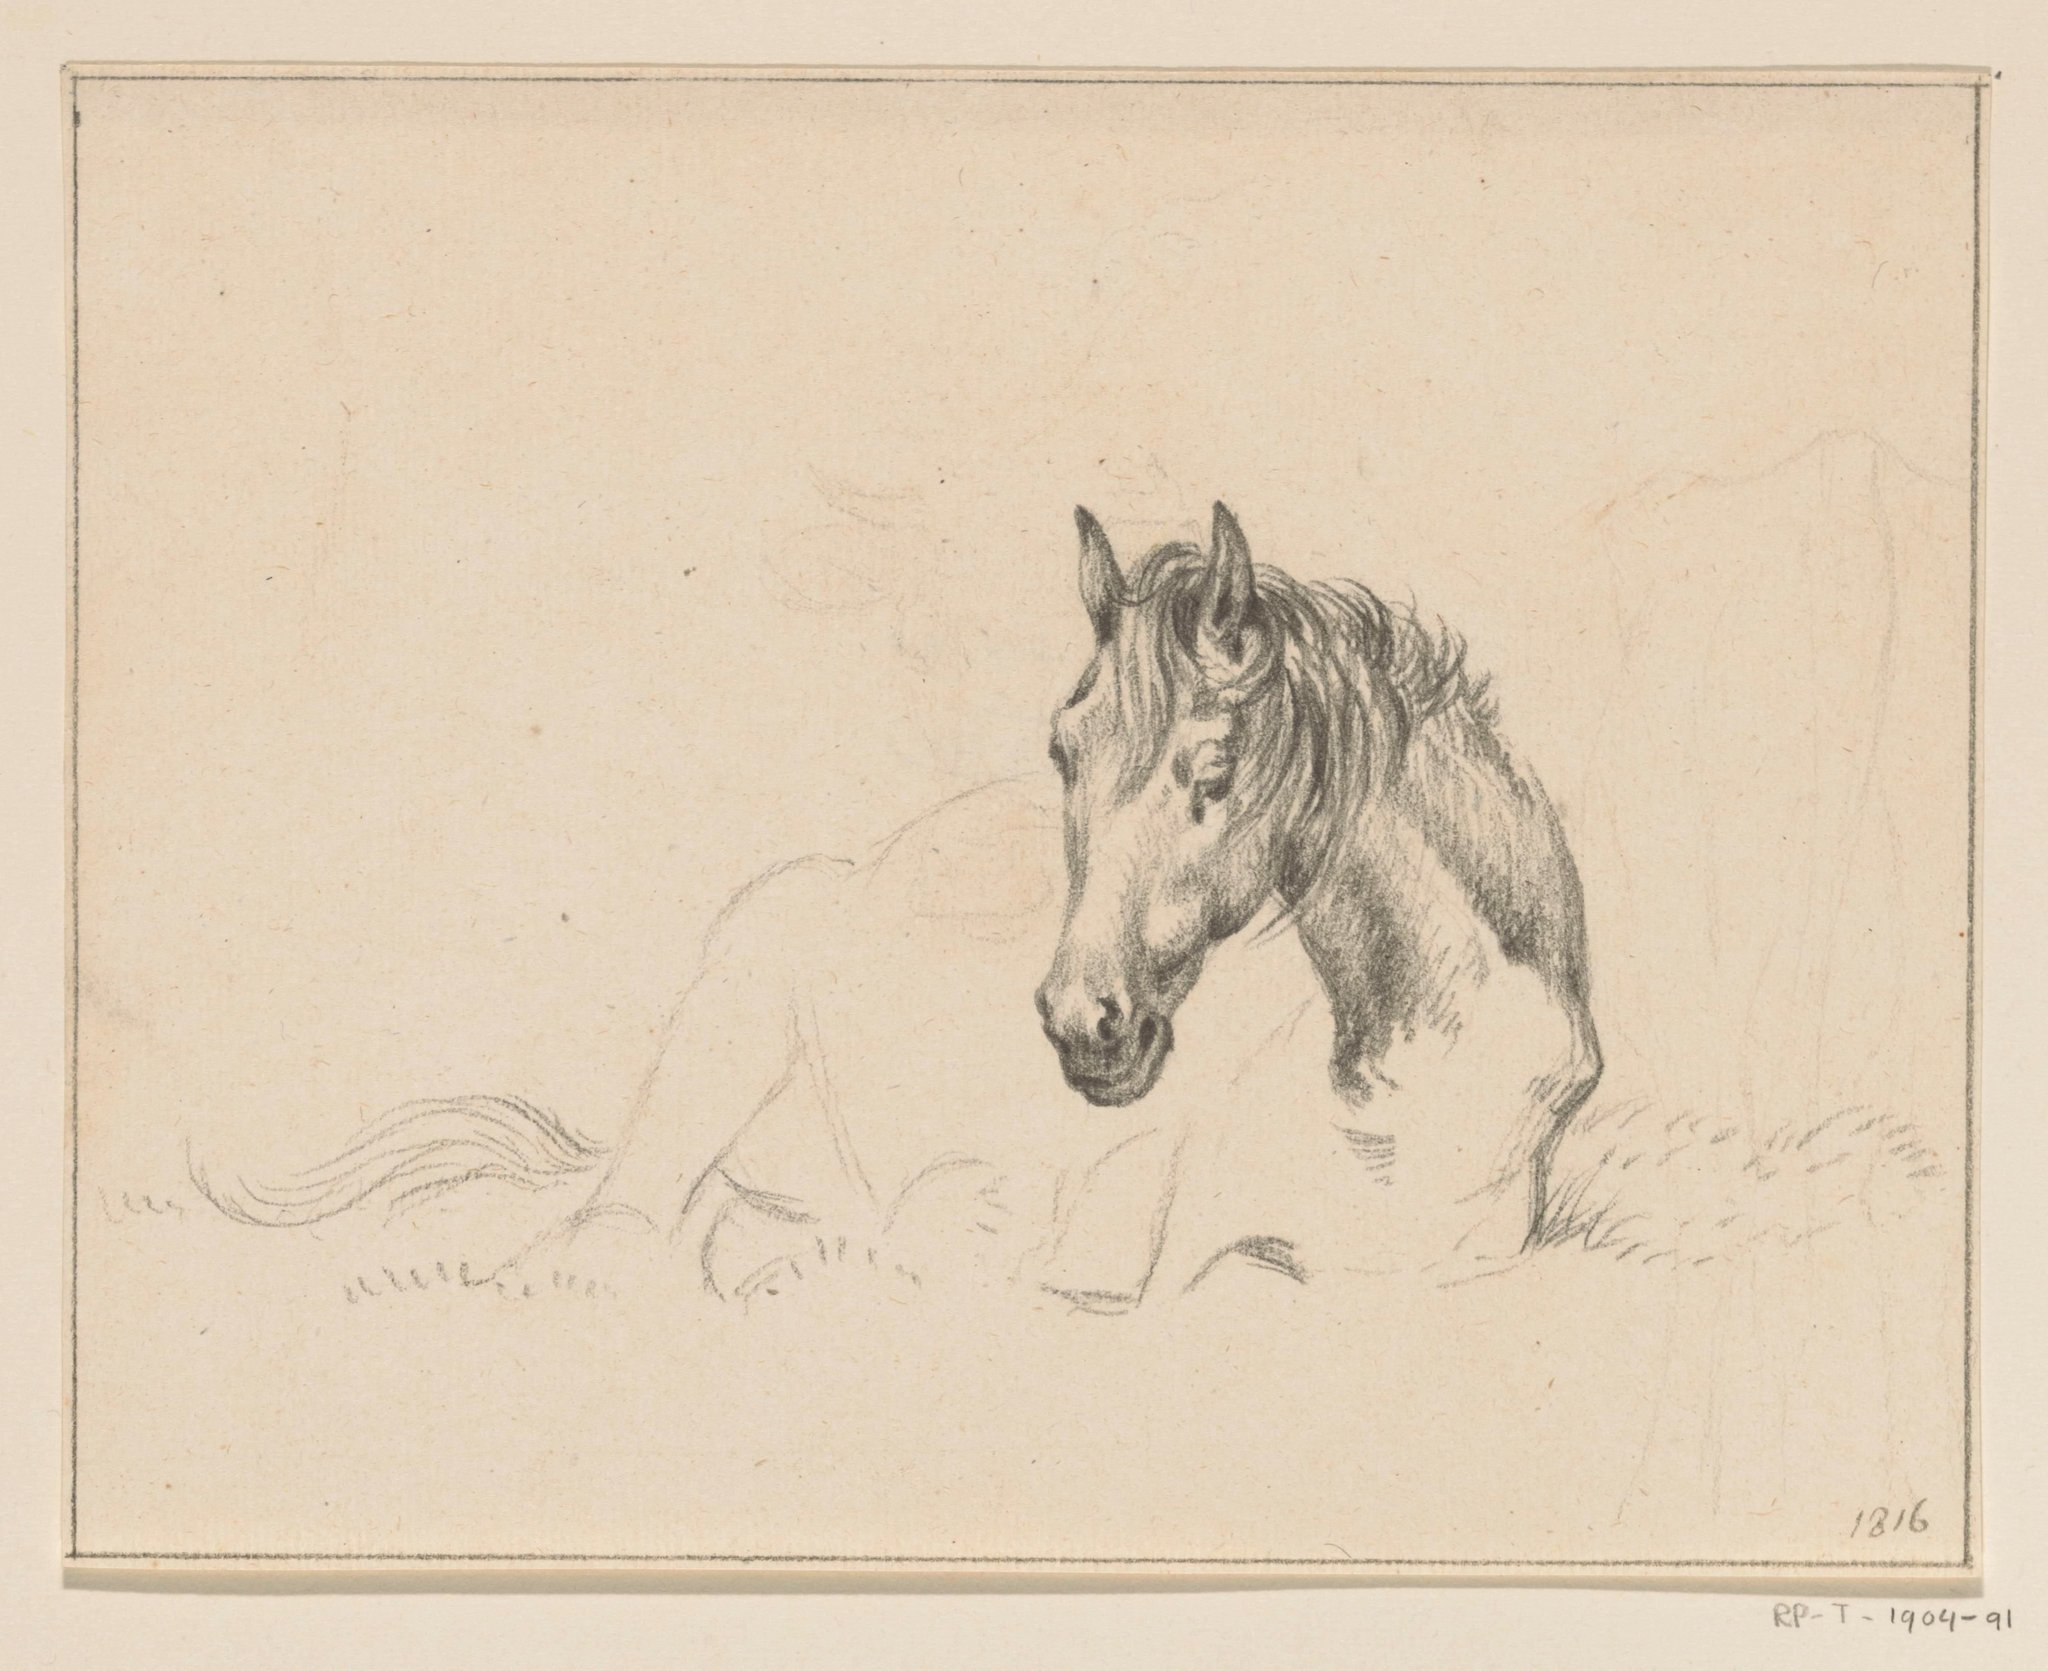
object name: drawing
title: Liggend paard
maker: jean bernard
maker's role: draughtsman, print maker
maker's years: 1765-1833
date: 1816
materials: chalk, paper, pencil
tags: horse